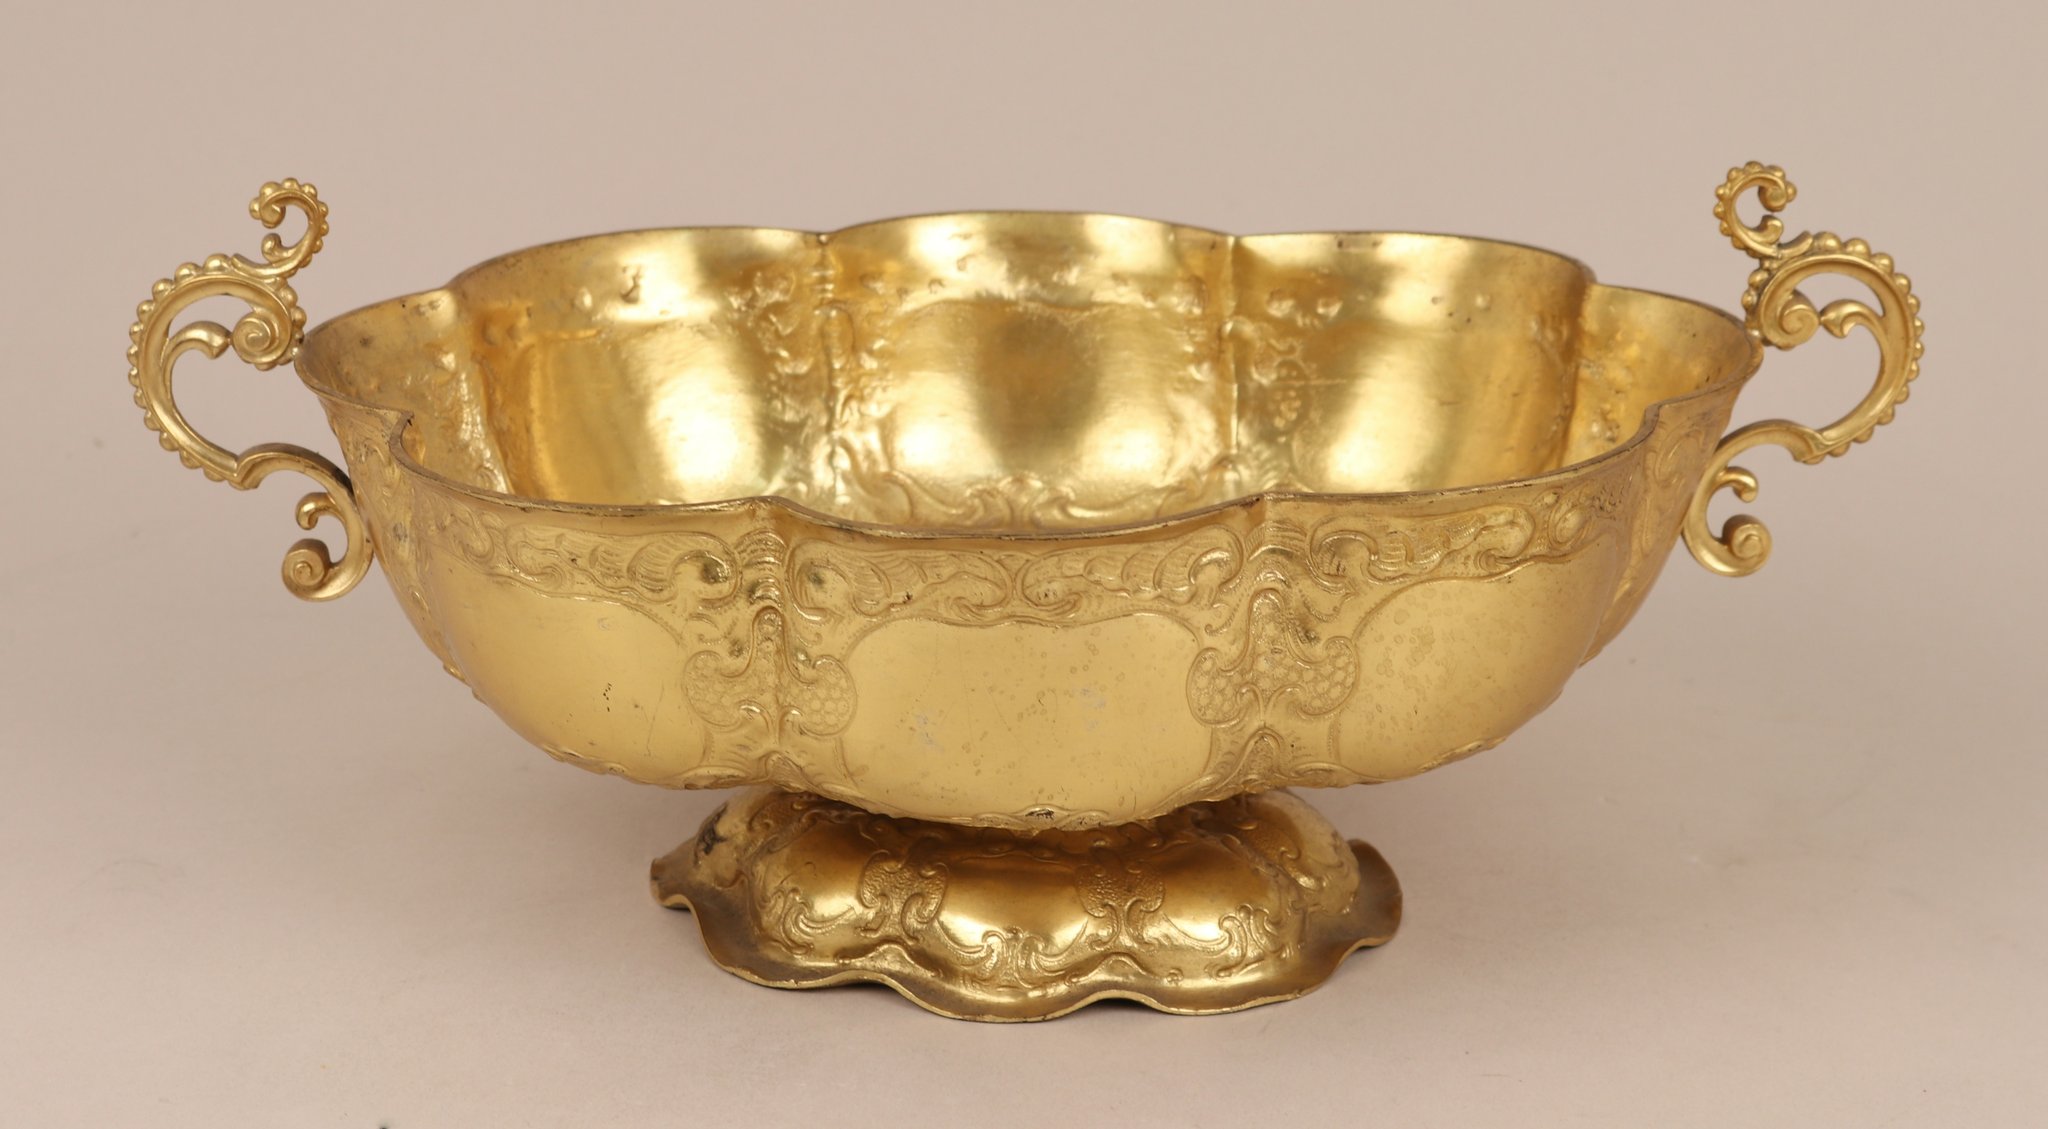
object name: bowl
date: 1801-1900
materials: metal, silver